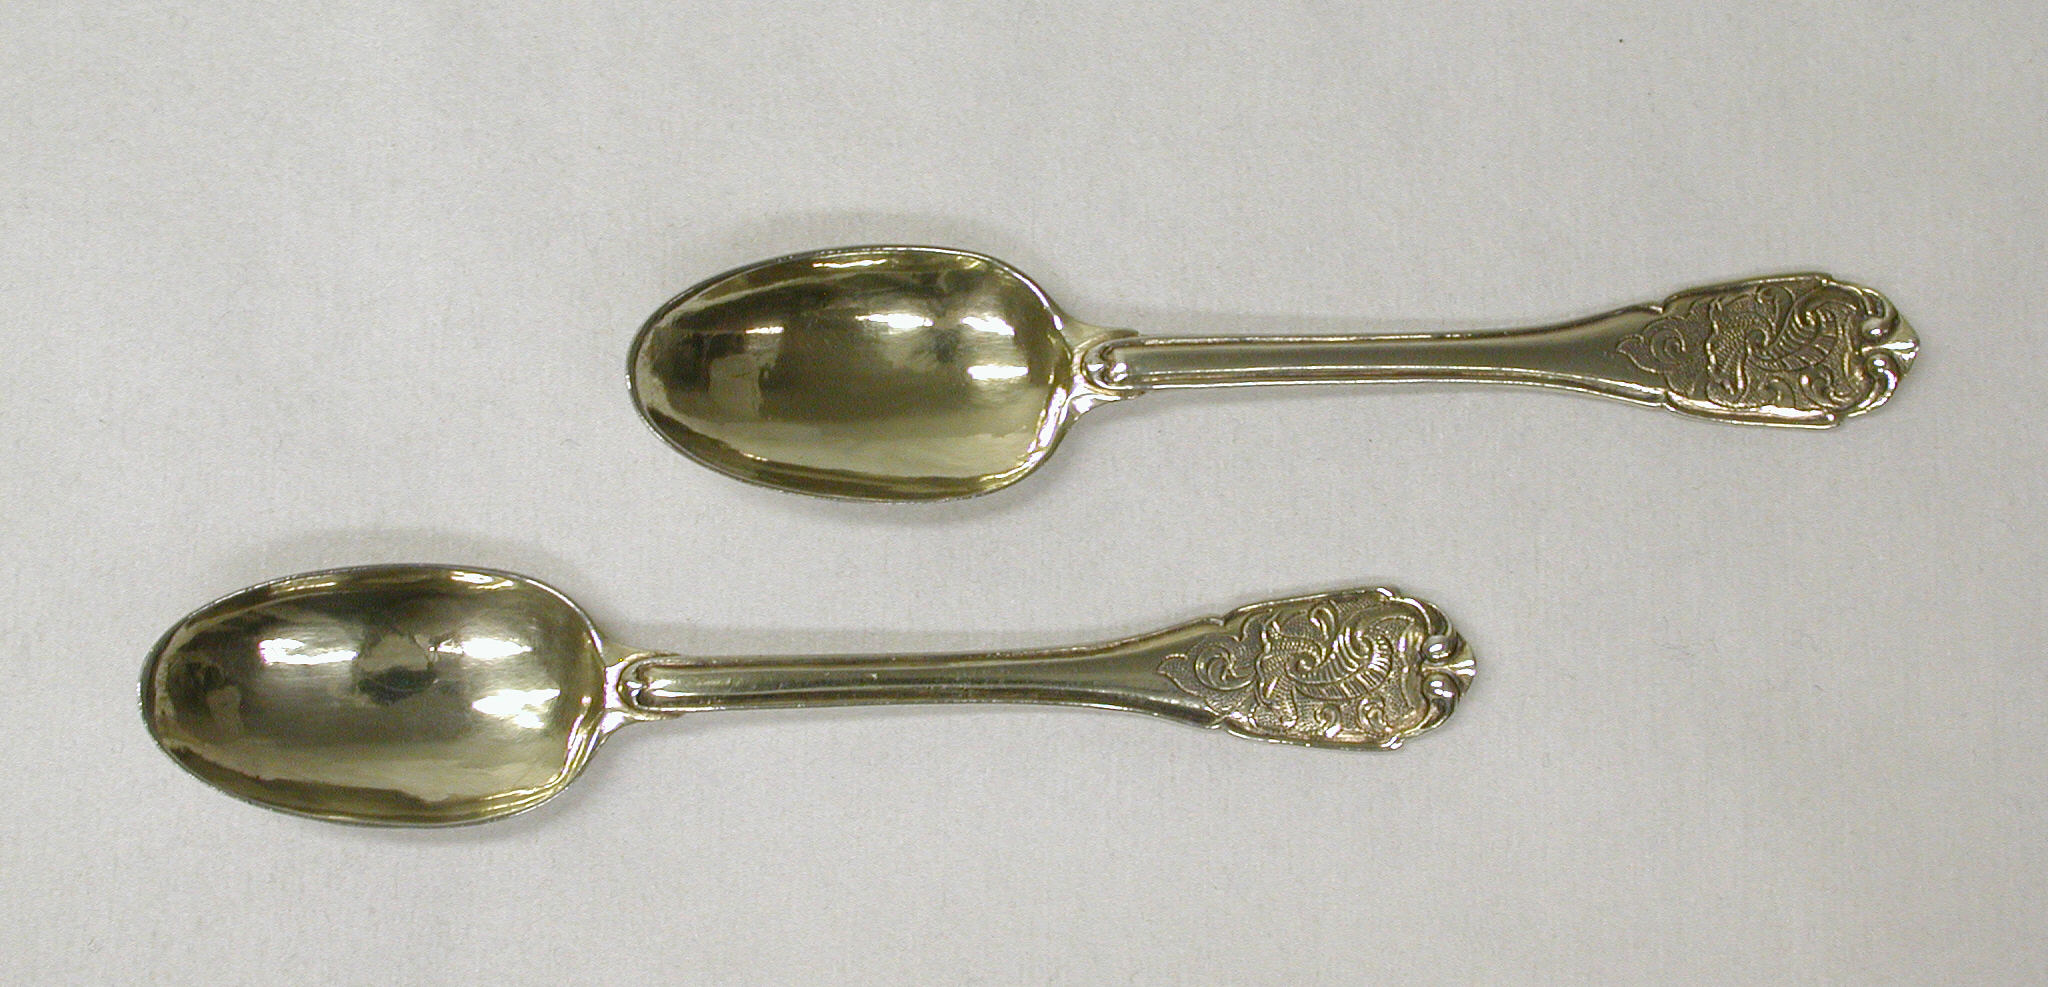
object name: coffee spoon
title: Coffee spoon (one of a pair)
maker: abraham warnberger iii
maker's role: maker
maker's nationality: german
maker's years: 1670-1753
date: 1743-1745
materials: silver gilt